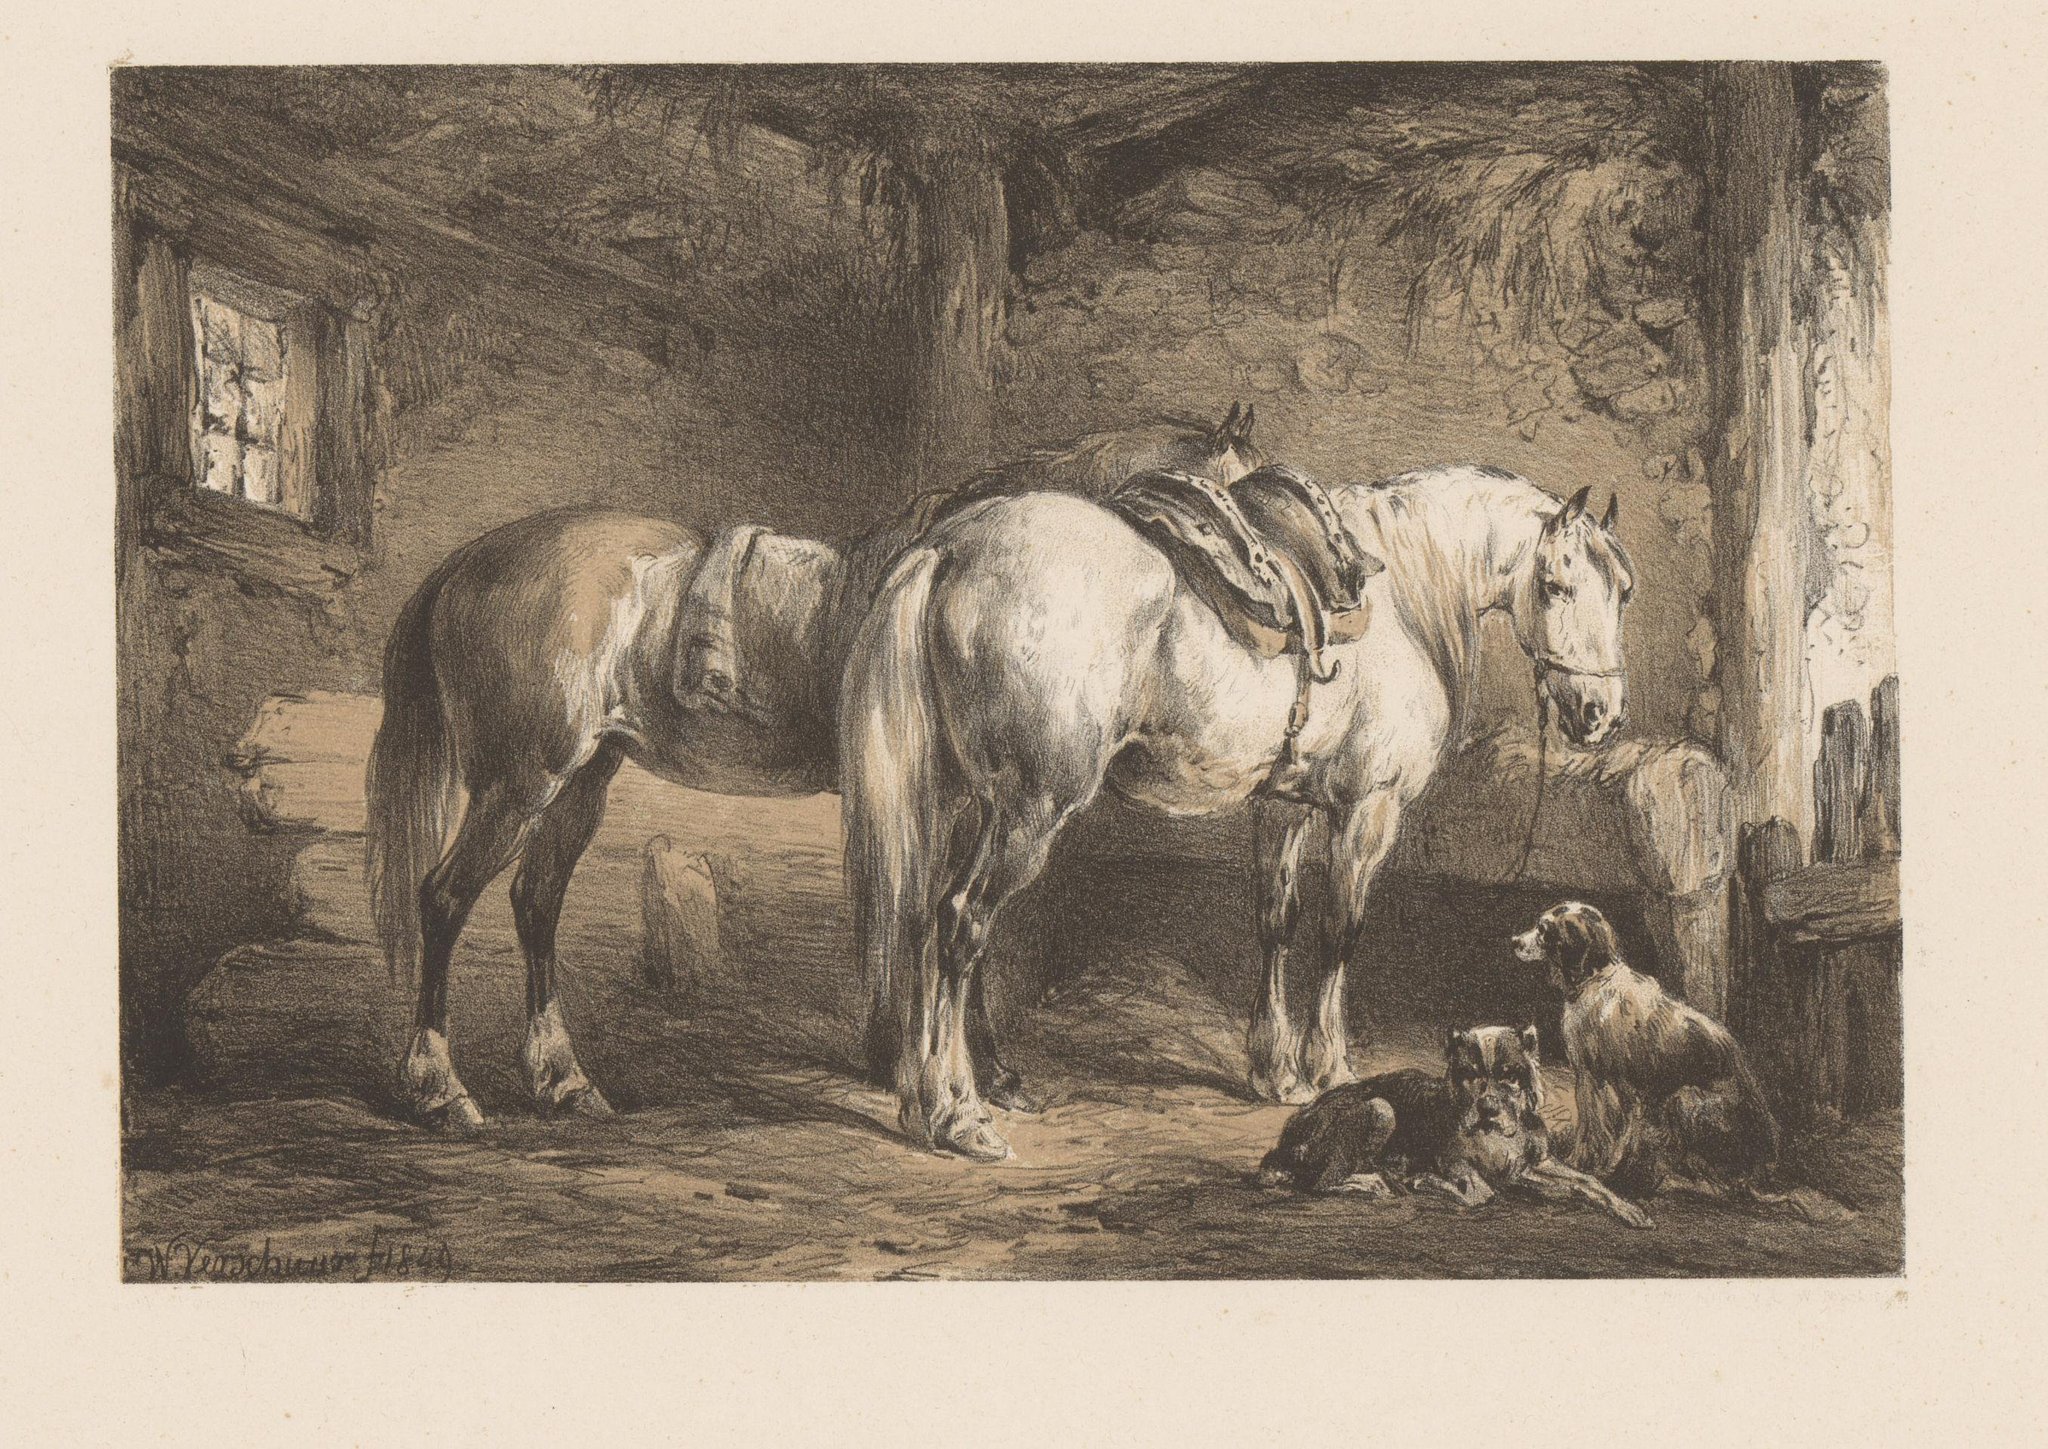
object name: print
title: Twee paarden en honden in een stal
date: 1849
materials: paper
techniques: tone lithography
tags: barn, dog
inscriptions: collector's mark: Lugt 2228